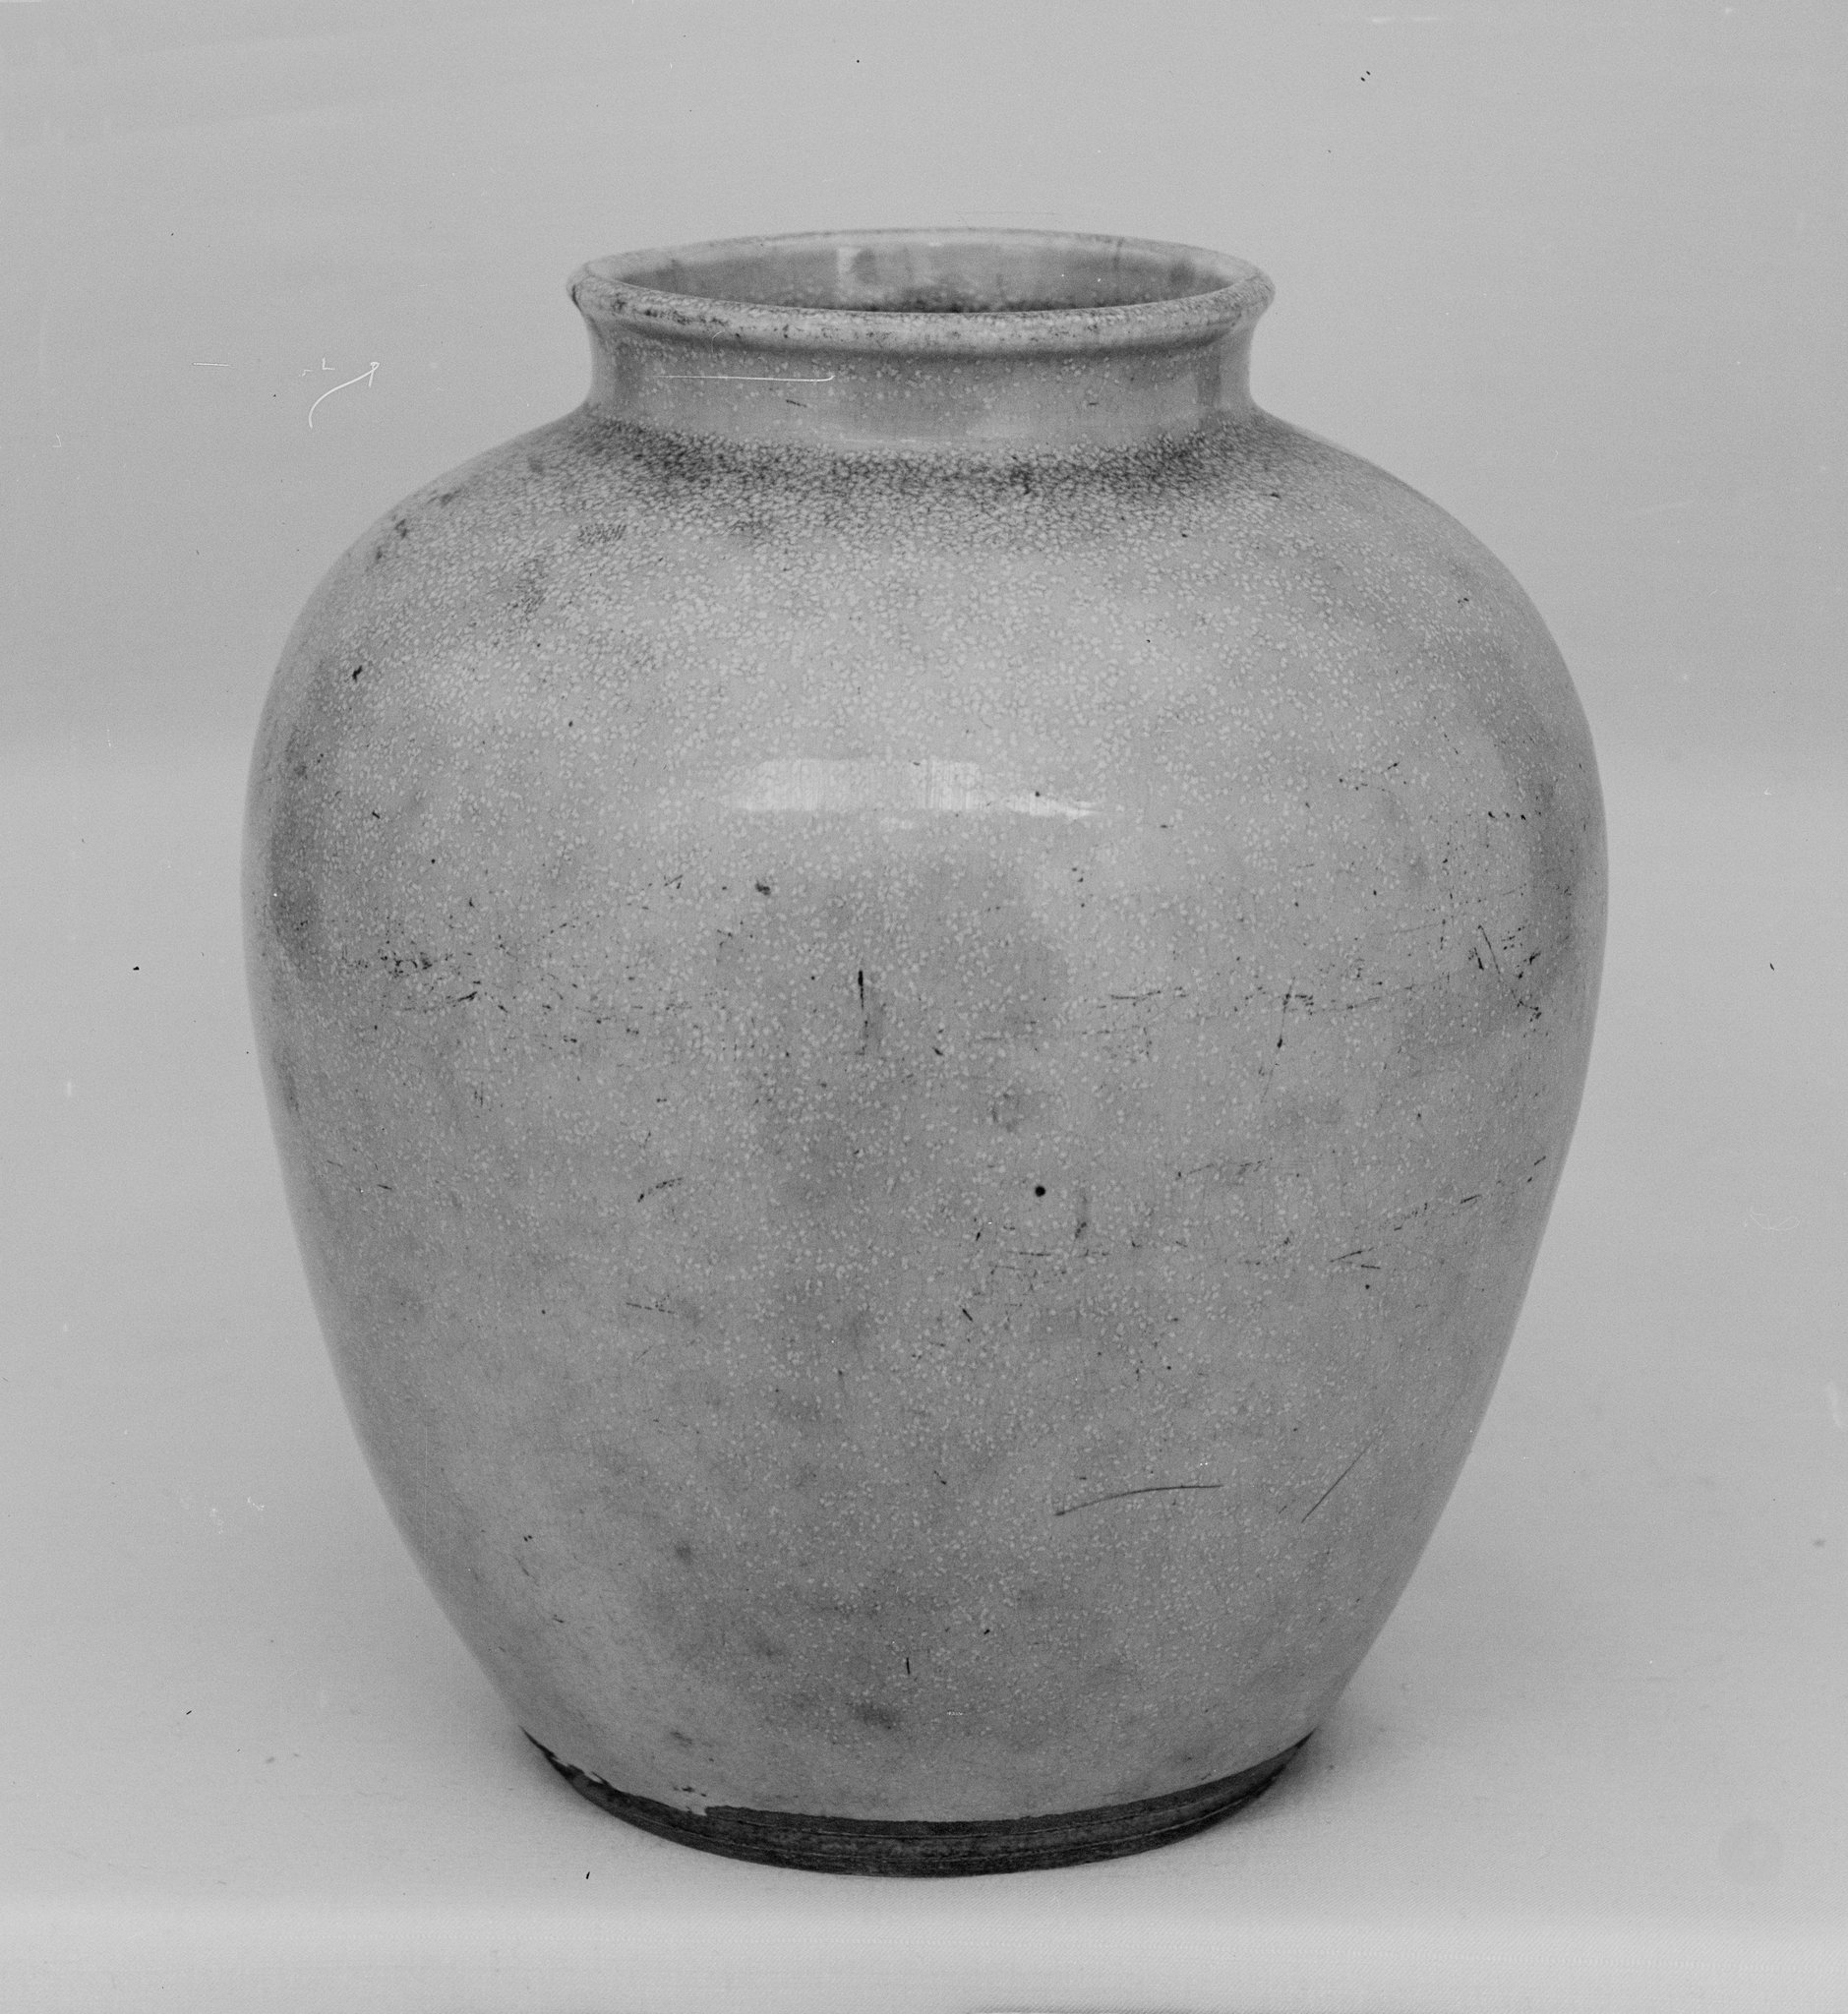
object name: jar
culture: japanese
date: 1801-1900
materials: clay, glaze